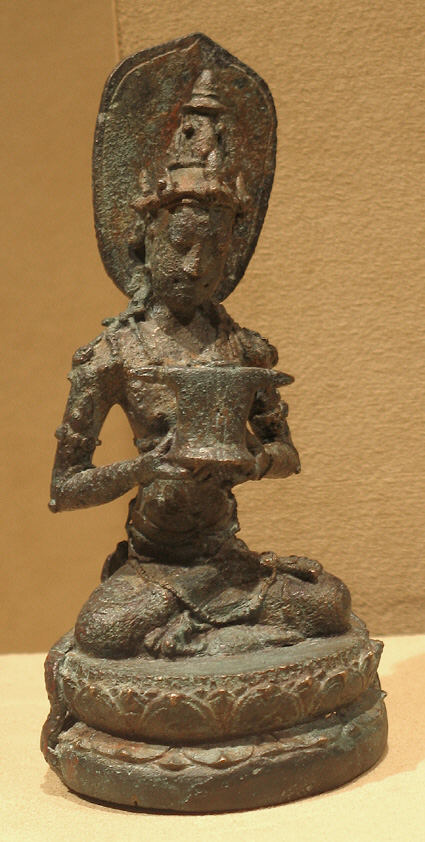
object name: figure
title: Seated Bodhisattva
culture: indonesian, java, ngandjuk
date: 967-1033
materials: bronze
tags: buddhism,bodhisattvas